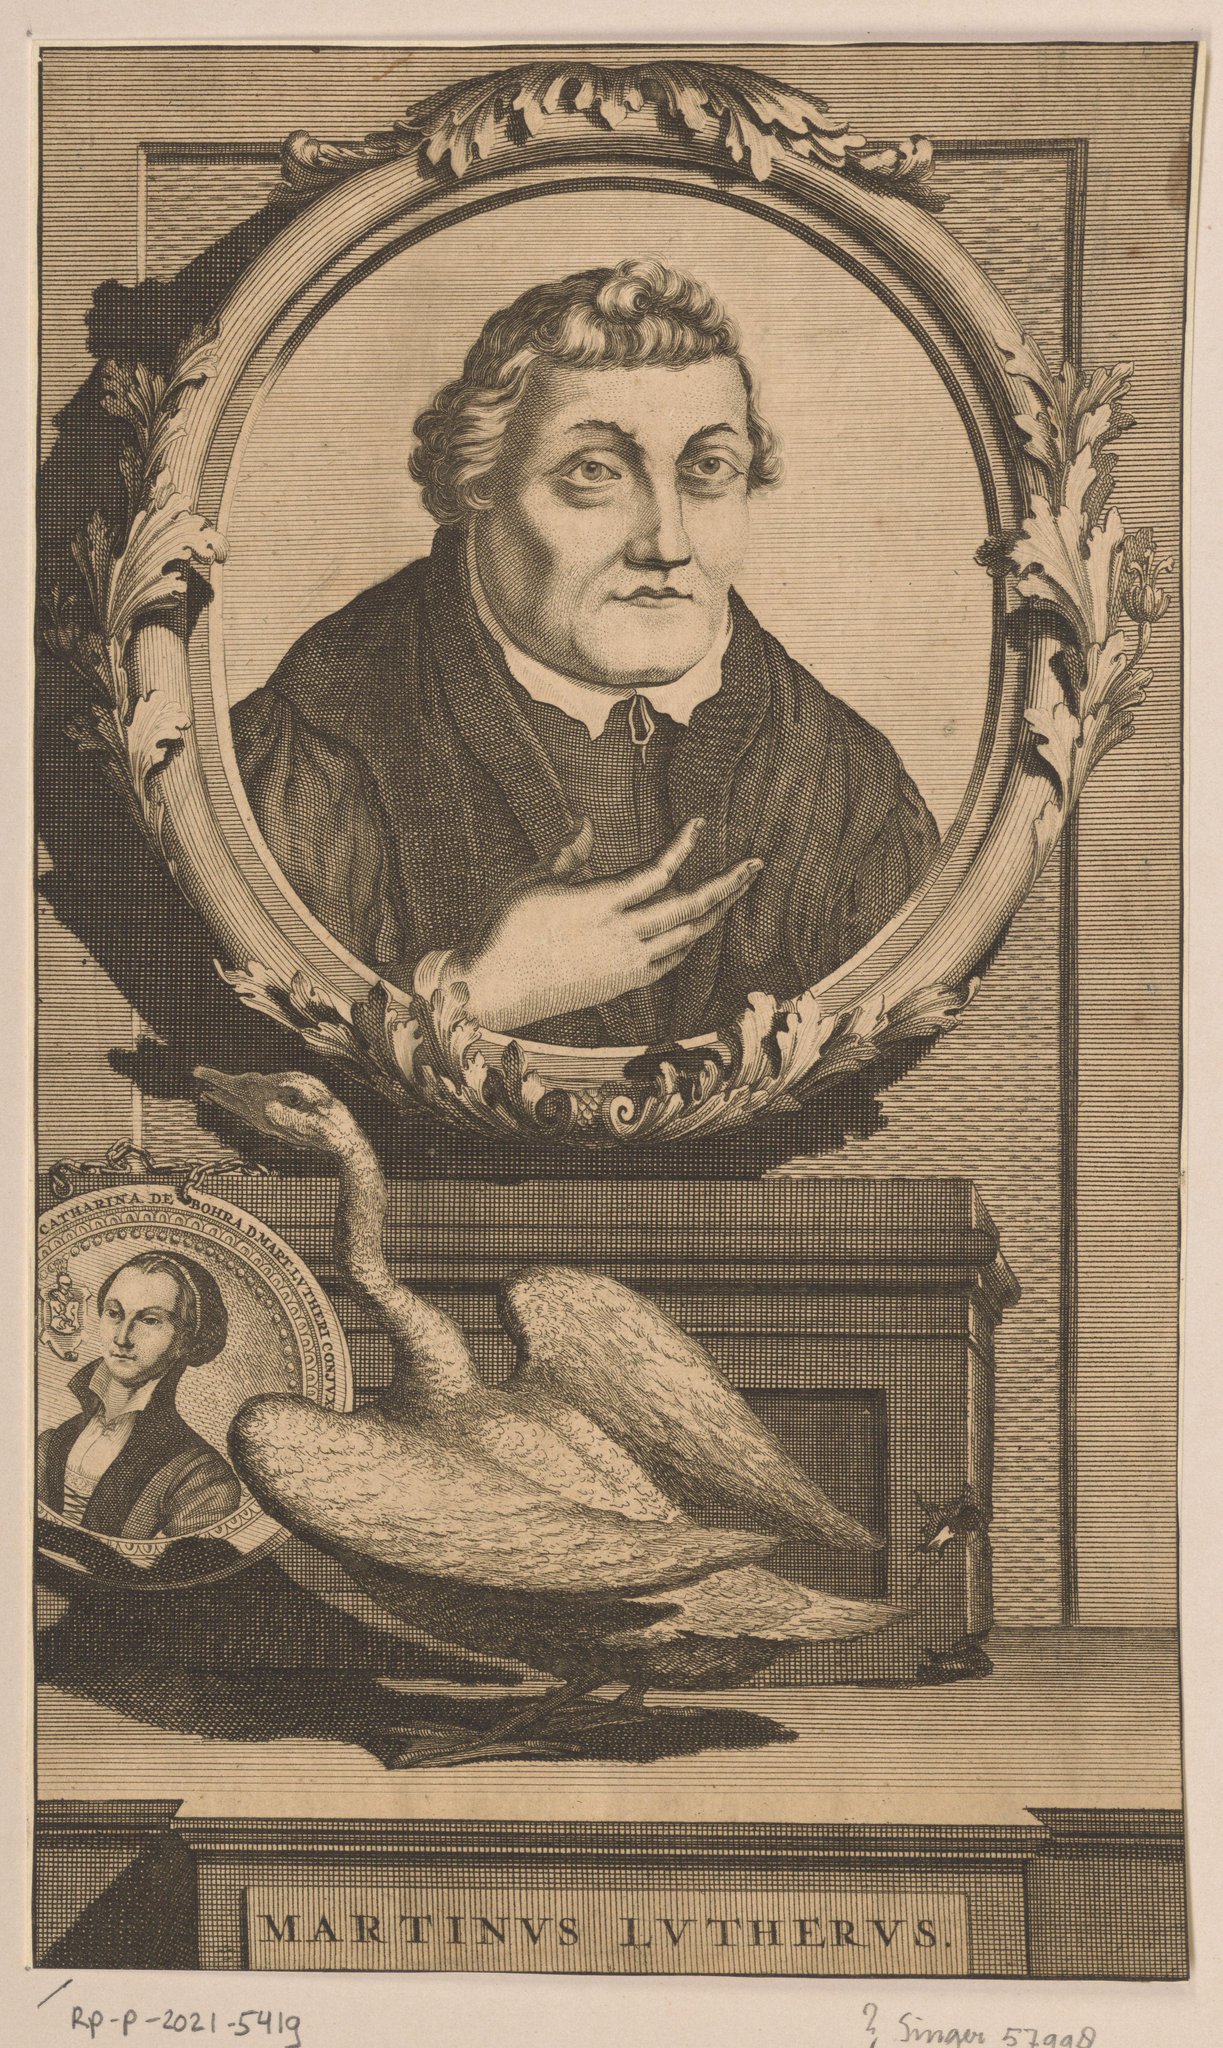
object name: print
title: Portret van Martin Luther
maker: Anonymous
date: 1700-1799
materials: paper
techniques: etching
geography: northern netherlands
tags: priest, martin luther, theologian, historical persons - bb - woman, water-birds: swan, ornament ~ medallion, historical persons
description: Portret van Luther in medaillon. Onder het portret een zwaan bij een portret in medaillon van Katharina von Bora.